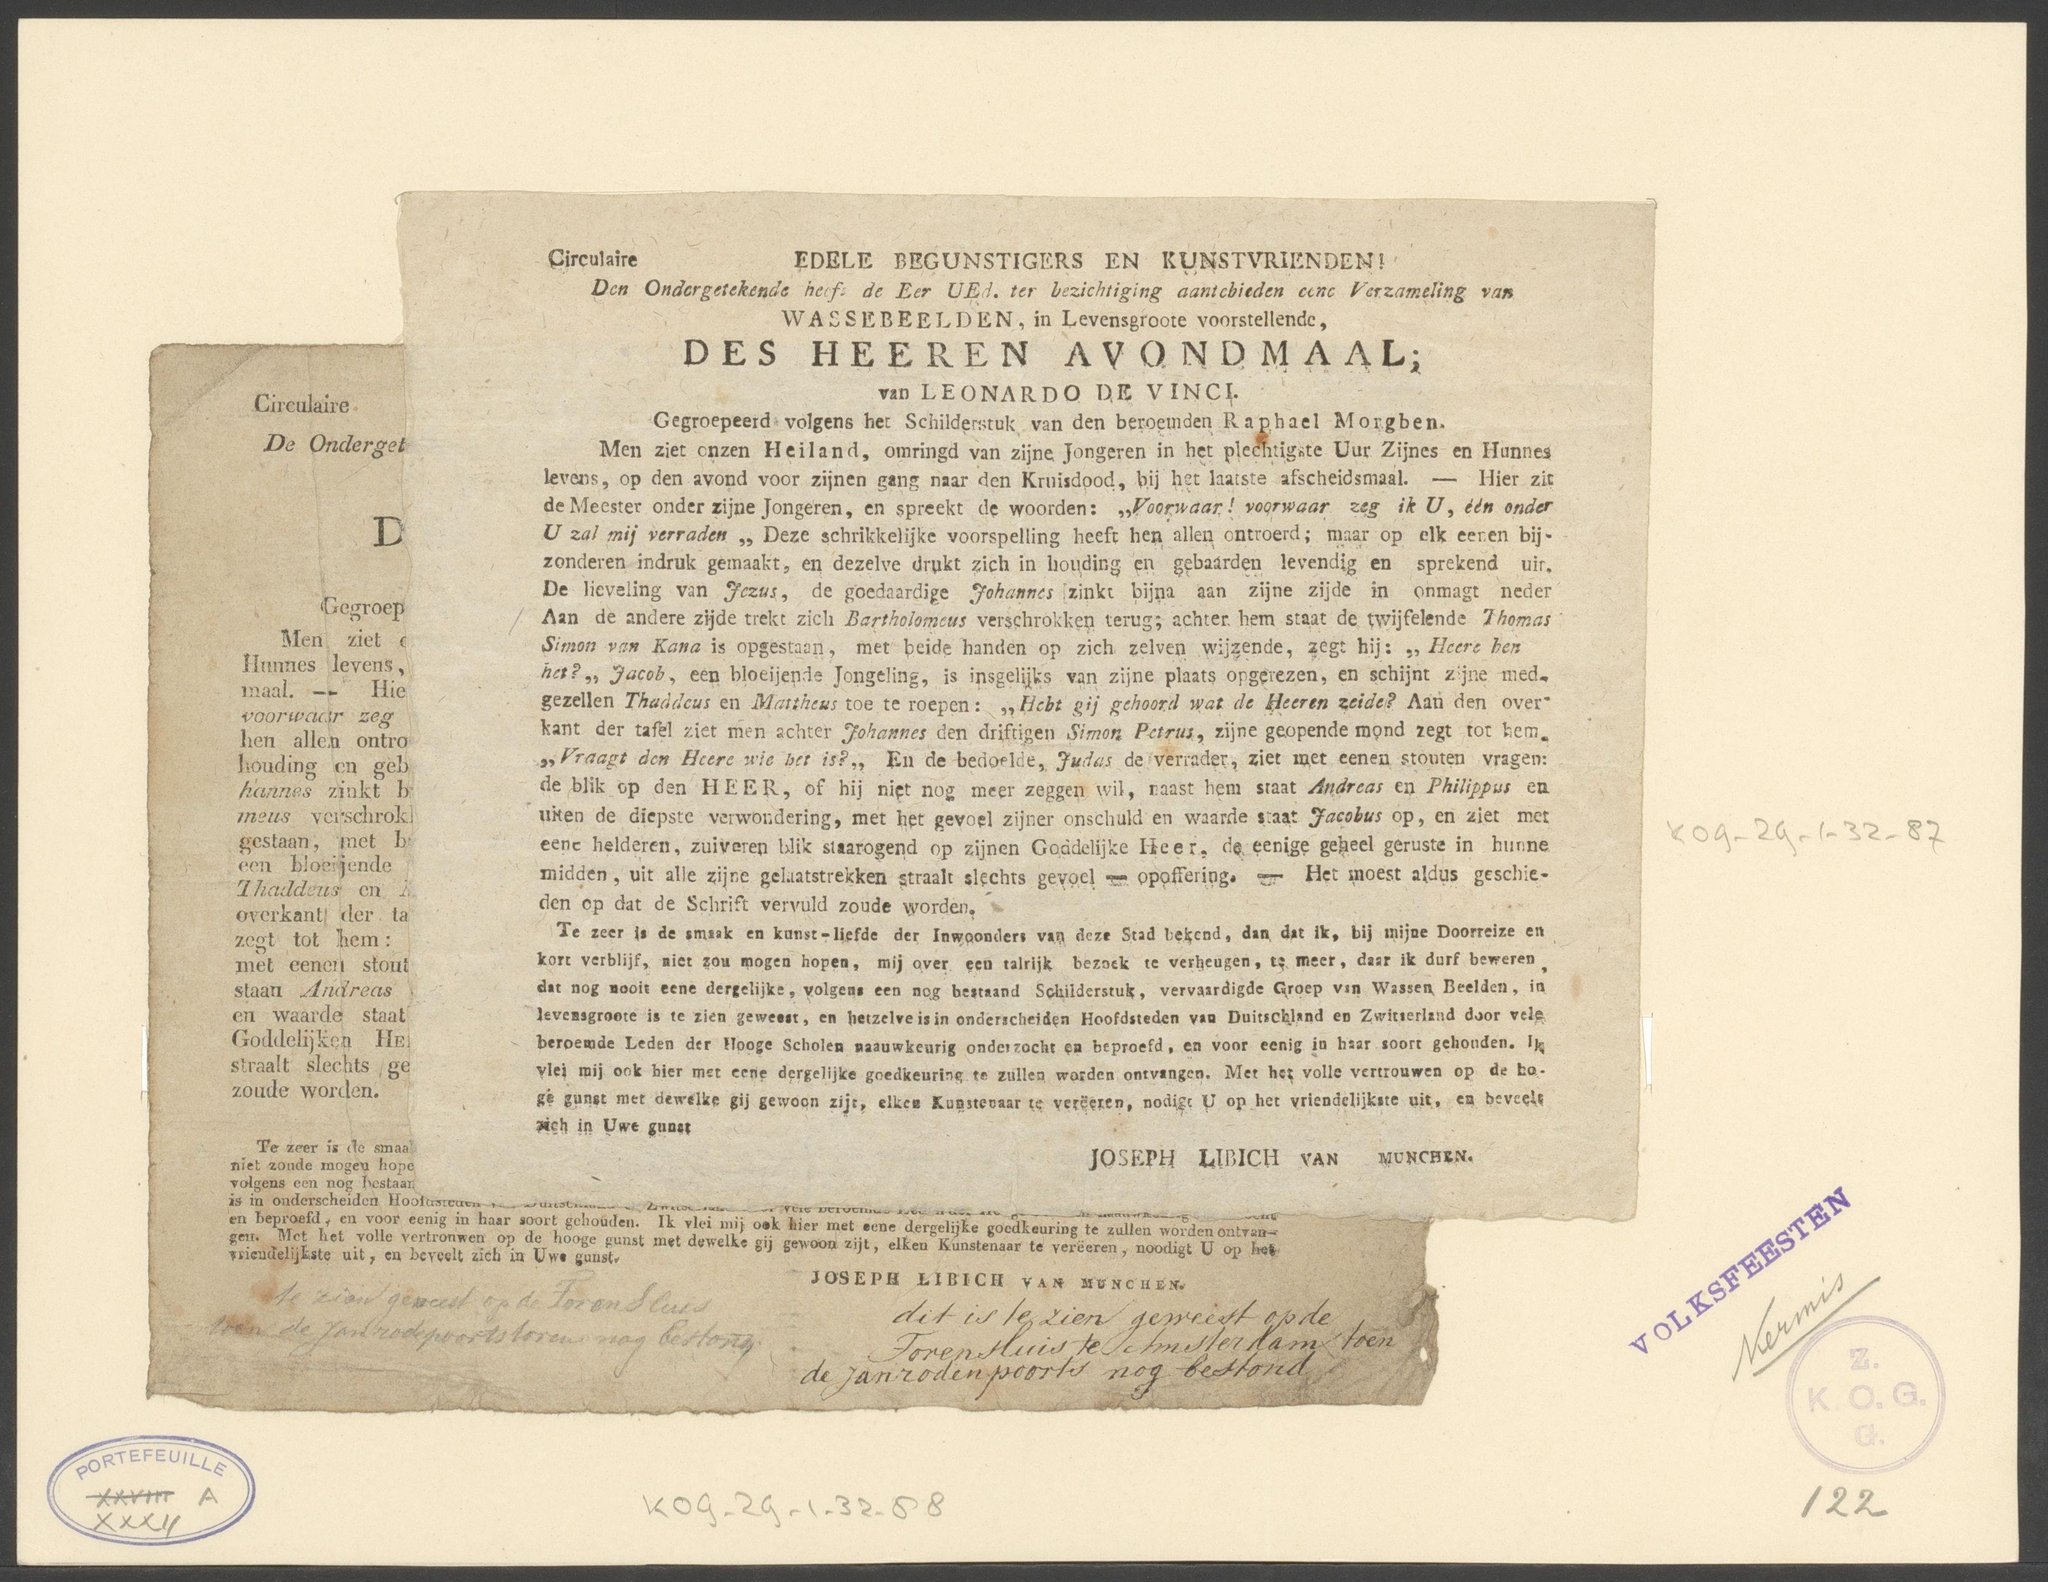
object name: reclamebiljet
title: Verzameling van Wassebeelden, in Levensgroote voorstellende, Des Heeren Avondmaal; van Leonardo de Vinci. Gegroepeerd volgens het Schilderstuk van den beroemden Raphael Morghen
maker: Anonymous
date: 1806-1815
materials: paper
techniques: letterpress printing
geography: amsterdam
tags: the episode of the last supper, wax-figure cabinet, pleasure fair and circus, amsterdam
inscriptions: collector's mark: Lugt 1641, collector's mark